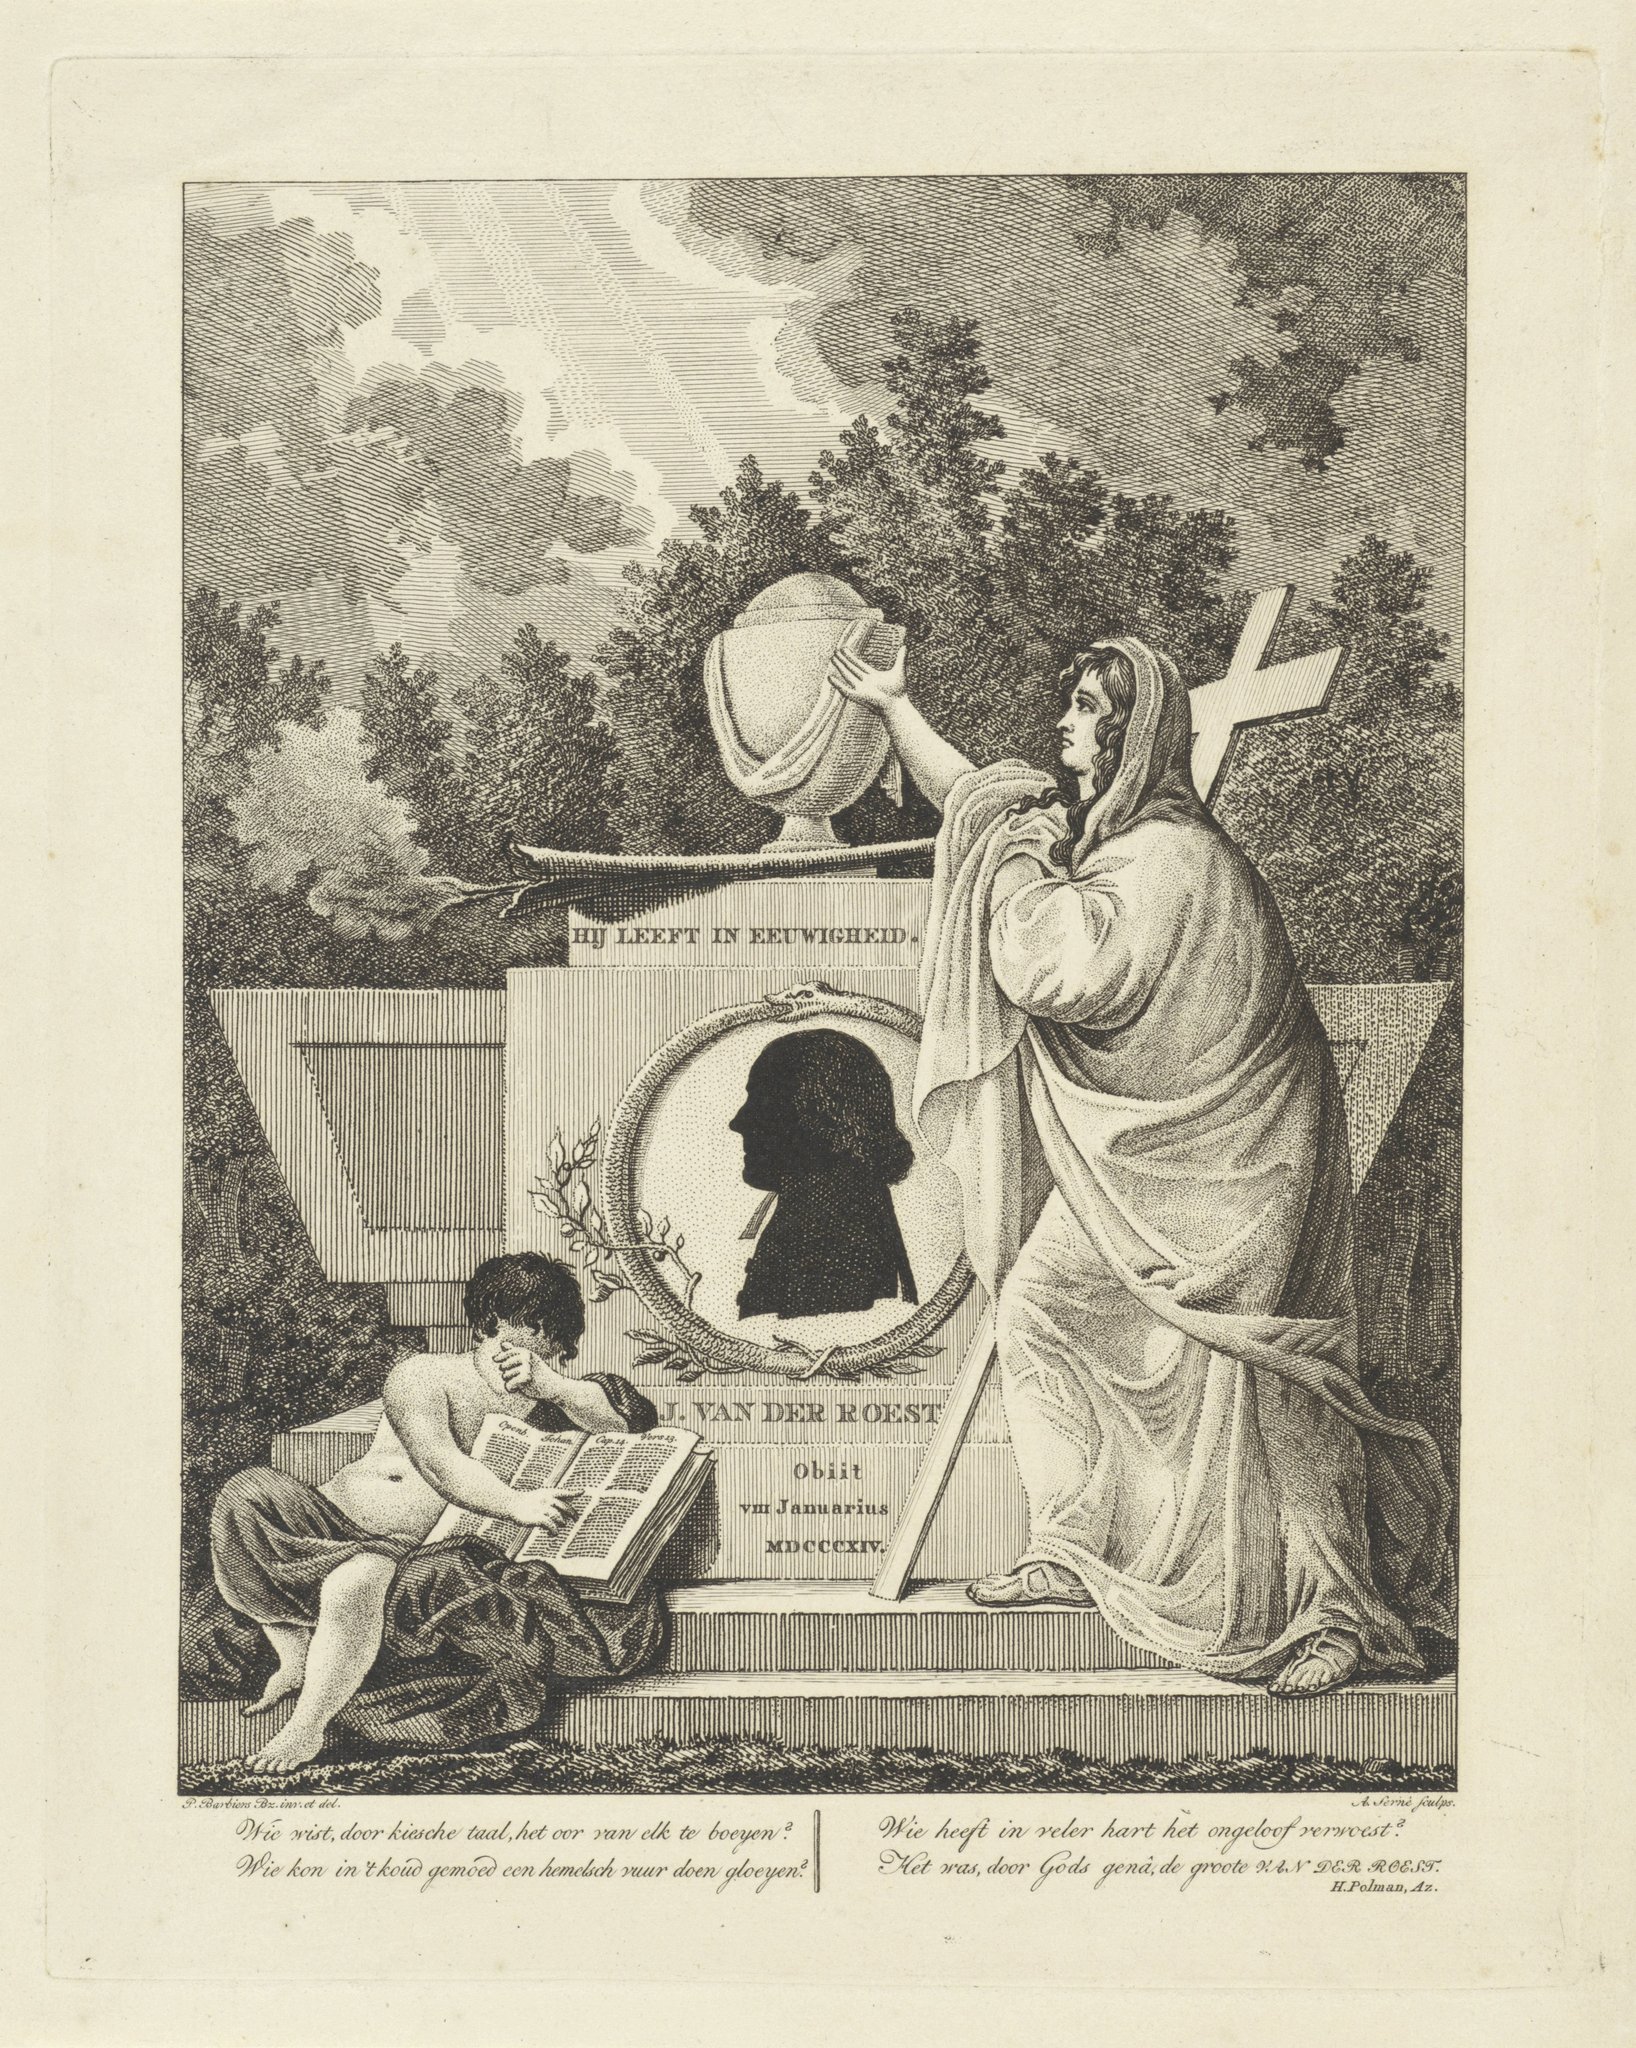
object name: print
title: Gedenkteken voor Jan van der Roest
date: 1814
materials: paper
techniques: engraving, etching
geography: haarlem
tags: haarlem, faith, 'fides'; 'fede', 'fede catholica', 'fede christiana', 'fede christiana catholica' (ripa) ~ one of the three theological virtues, serpent ouroboros, other memorial structures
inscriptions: collector's mark: Lugt 2228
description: Een monument voor predikant en schrijver Jan van der Roest met daarop zijn silhouetportret omringd door een slang die zich in de staart bijt. Het Geloof wijst op de hemel, het kruis staat naast haar. Een putto treurt en wijst op een opengeslagen bijbel met een verwijzing naar Op. 14:13. Onder de voorstelling een vierregelig vers in het Nederlands.